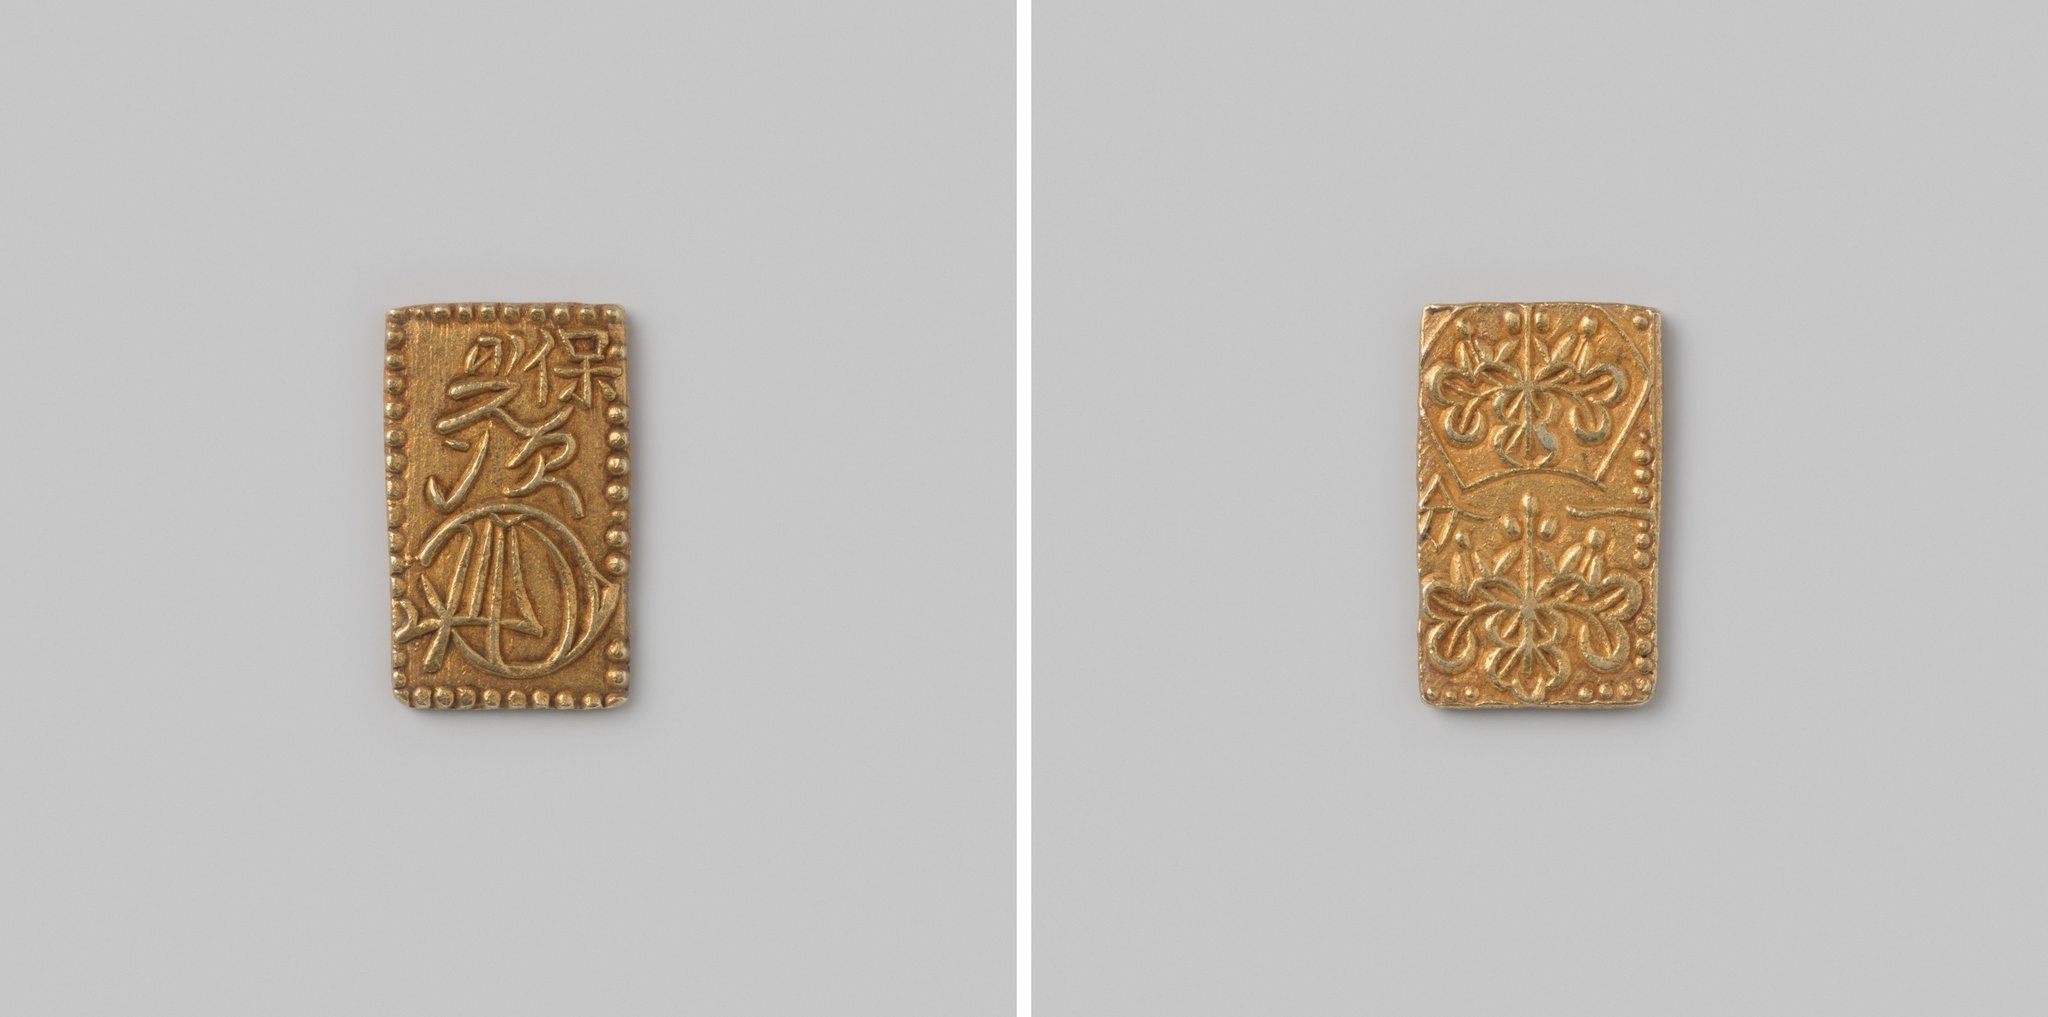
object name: twee sjoe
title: Ni sjoe of 2 sjoe van het keizerrijk Japanvan keizer Nin Kau uit het Tenpo tijdperk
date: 1842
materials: gold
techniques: striking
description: Gouden rechthoekige munt. Voorzijde: twee naar elkaar toegewende bloem-motieven, waartussen waarde-aanduiding: twee, aangegeven door twee liggende strepen. Keerzijde: binnen rechthoek onder elkaar geplaatste motieven.